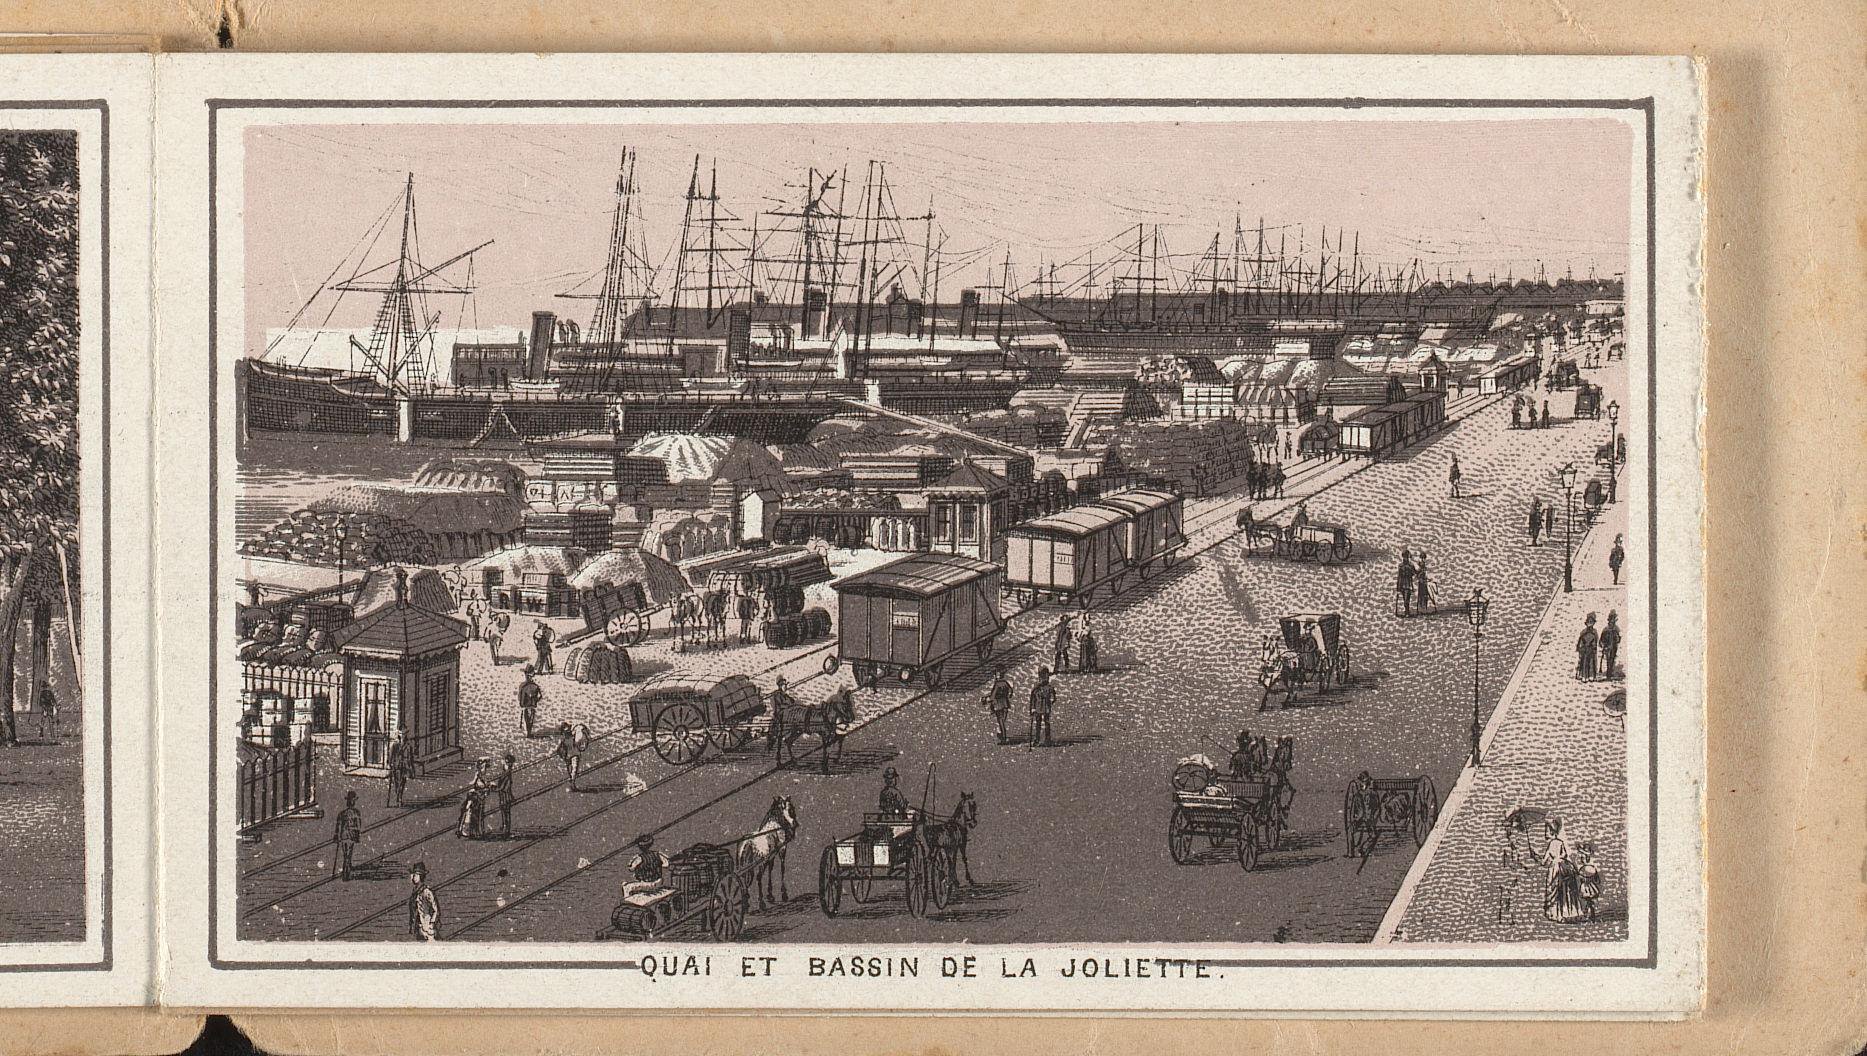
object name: print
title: Quai et Bassin de la Joliette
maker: Anonymous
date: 1890-1910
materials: cardboard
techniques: lithograph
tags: harbour, quay (+ city(-scape) with figures, staffage), marseille